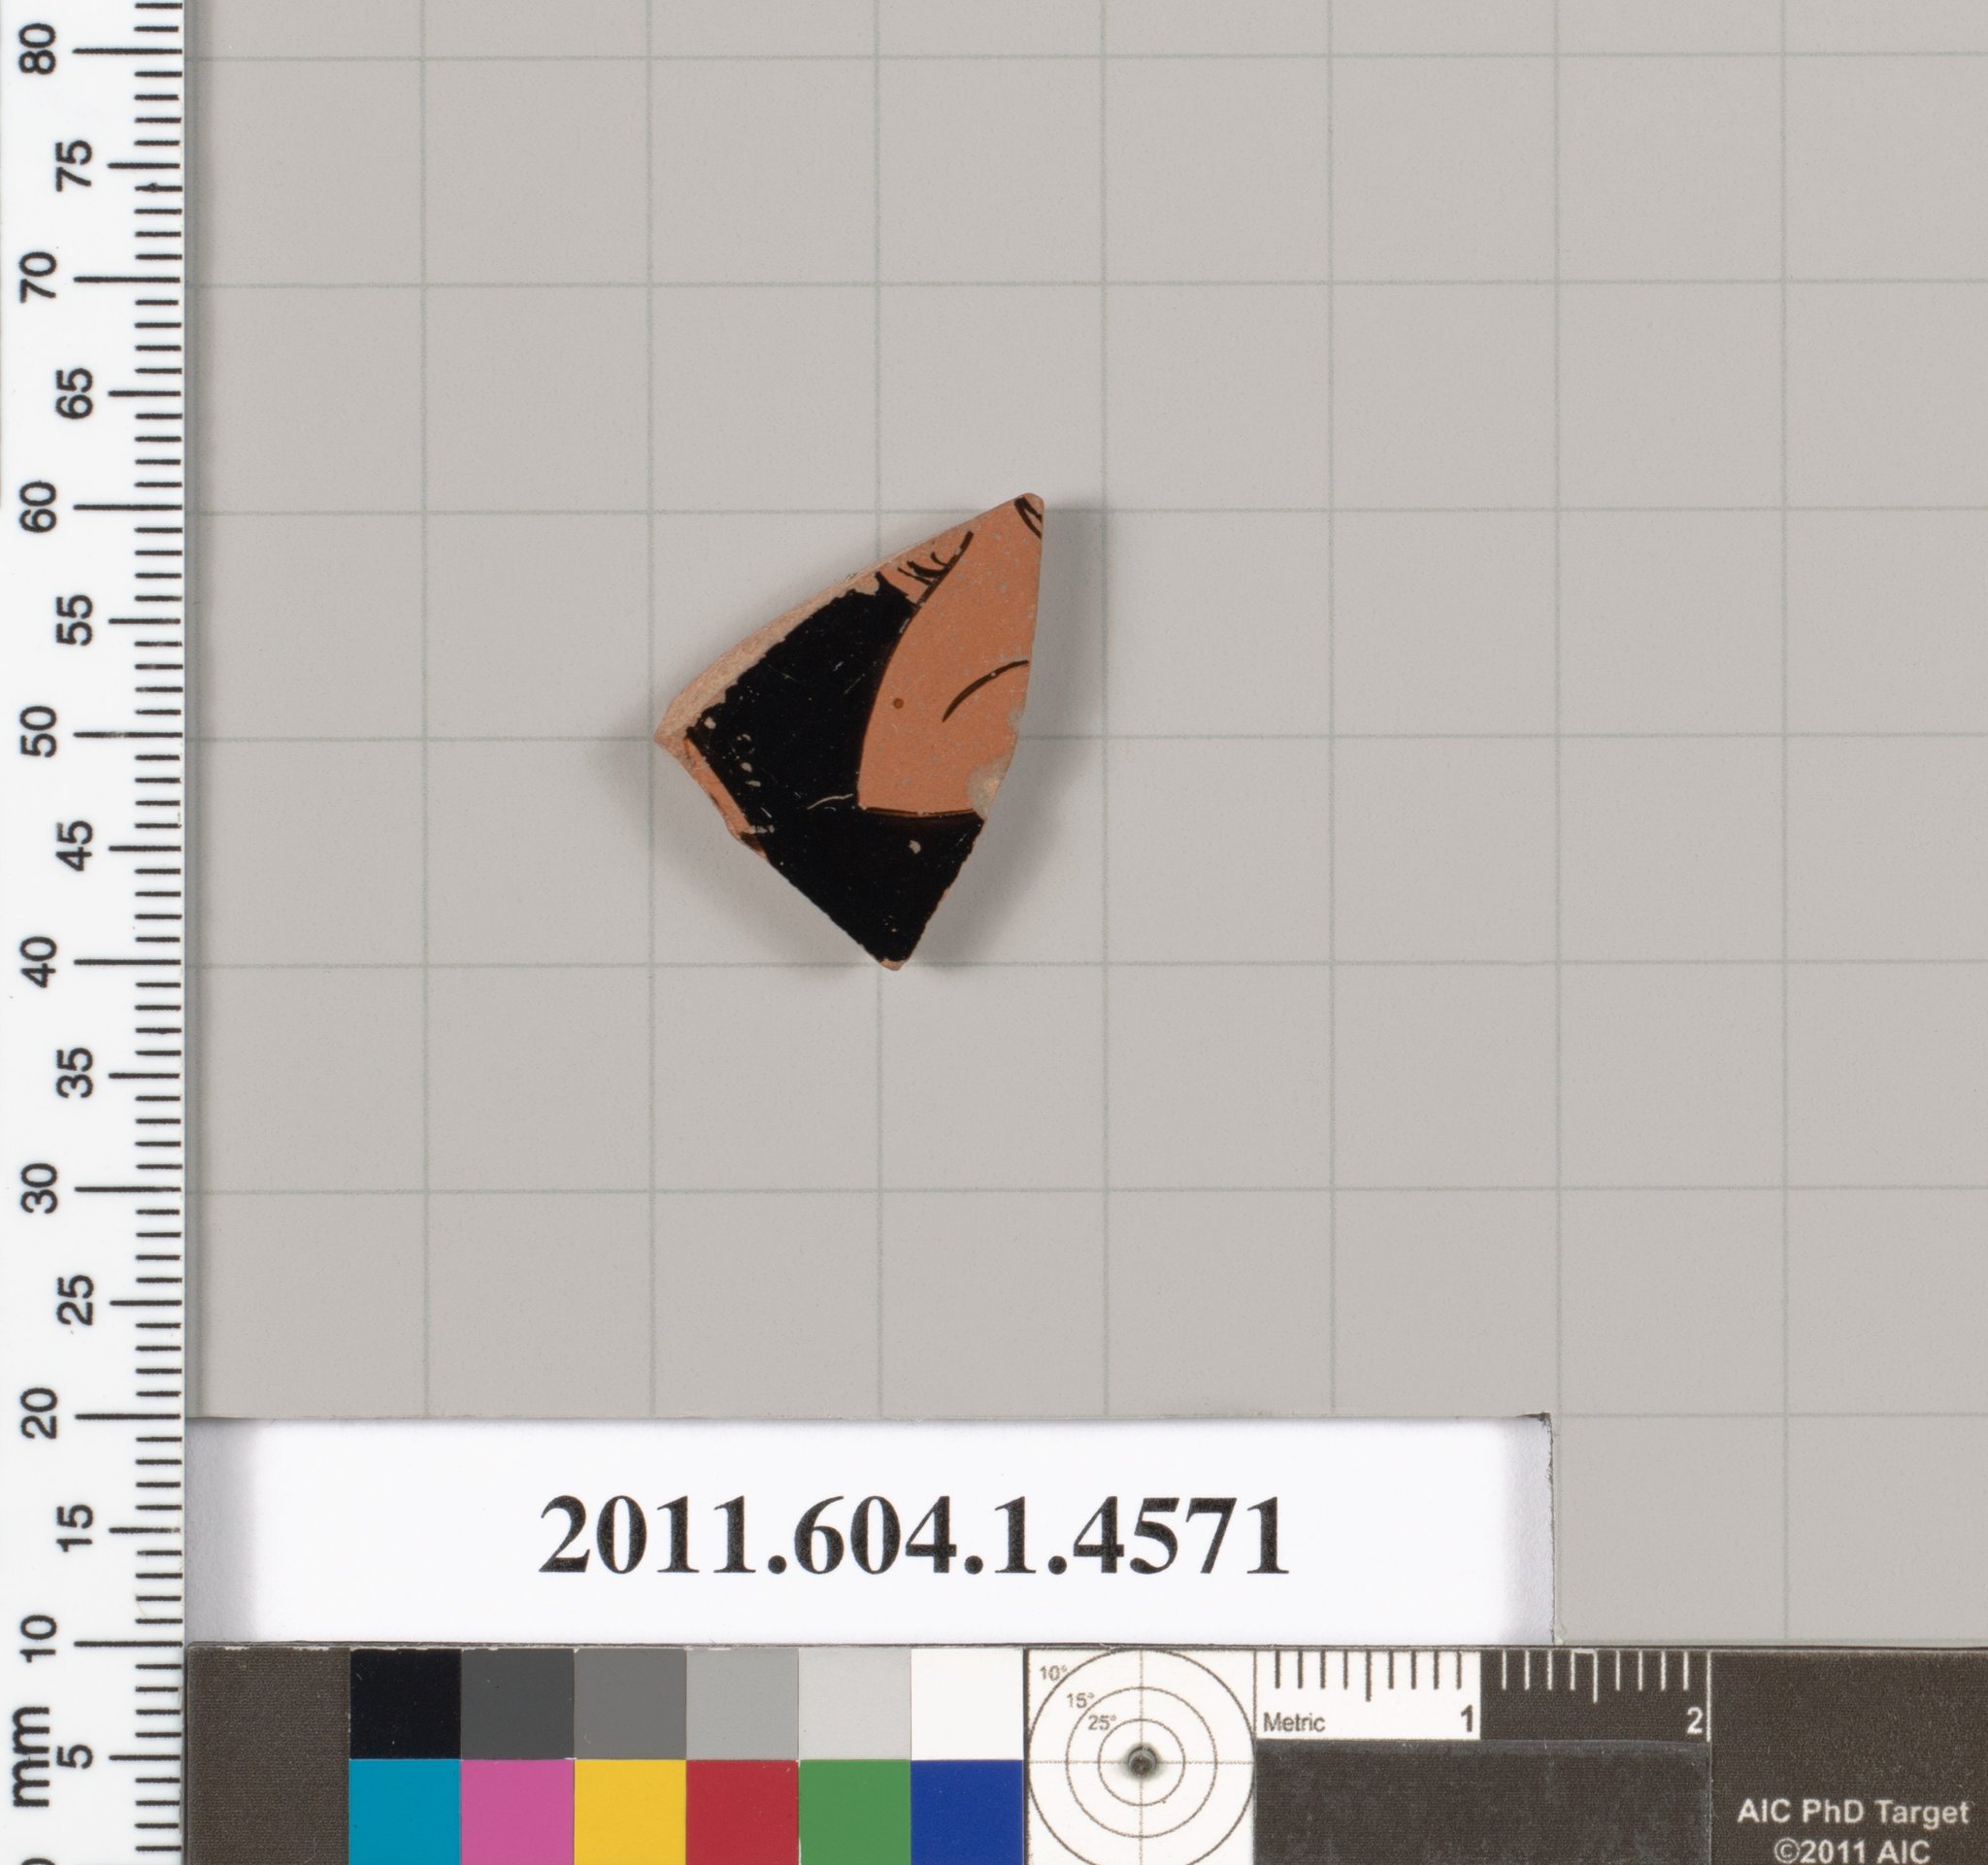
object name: kylix fragment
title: Terracotta fragment of a kylix (drinking cup)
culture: greek, attic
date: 500-480 BCE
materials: terracotta